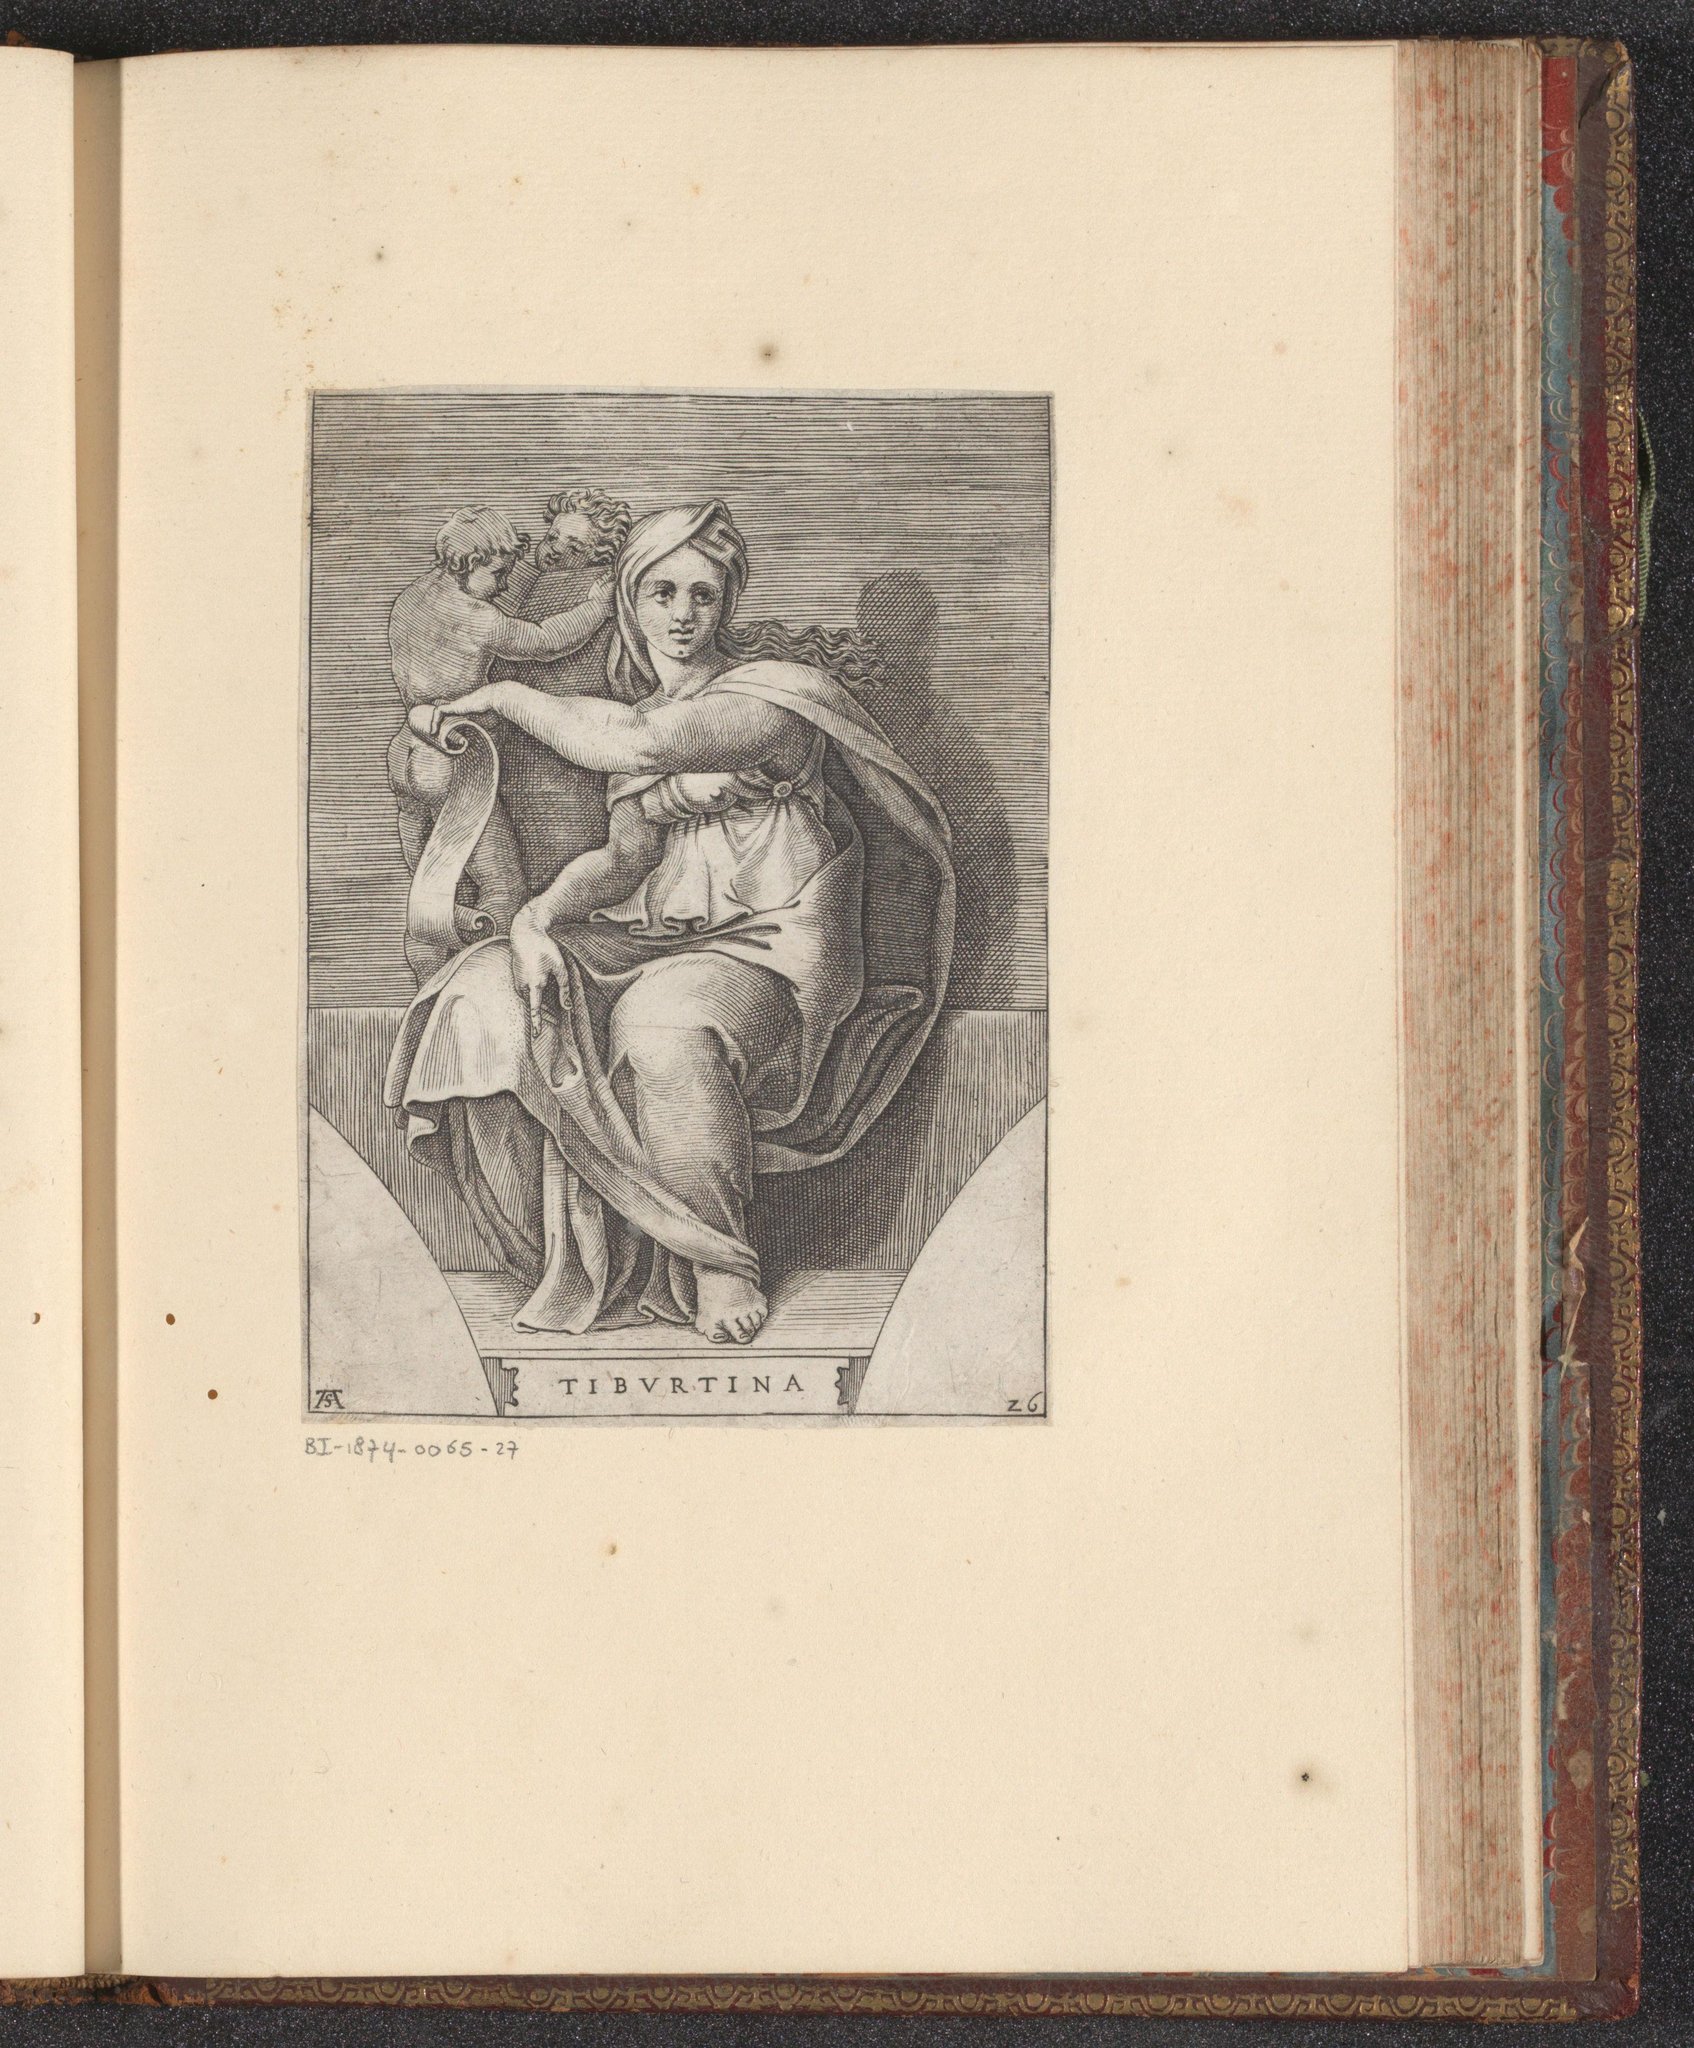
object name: album leaf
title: Schilderingen in de Sixtijnse kapel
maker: adamo scultori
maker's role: painter, print maker, sculptor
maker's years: 1530-1585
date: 1585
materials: paper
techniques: engraving, intaglio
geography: italy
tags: sibyls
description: Tiburtijnse Sibille zittend met een boekrol. Links twee kleine figuren. Eén van de Sibillen van Michelangelo's plafondschildering. Titel in ondermarge en genummerd rechtsonder: 26. De prent maakt deel uit van een album.